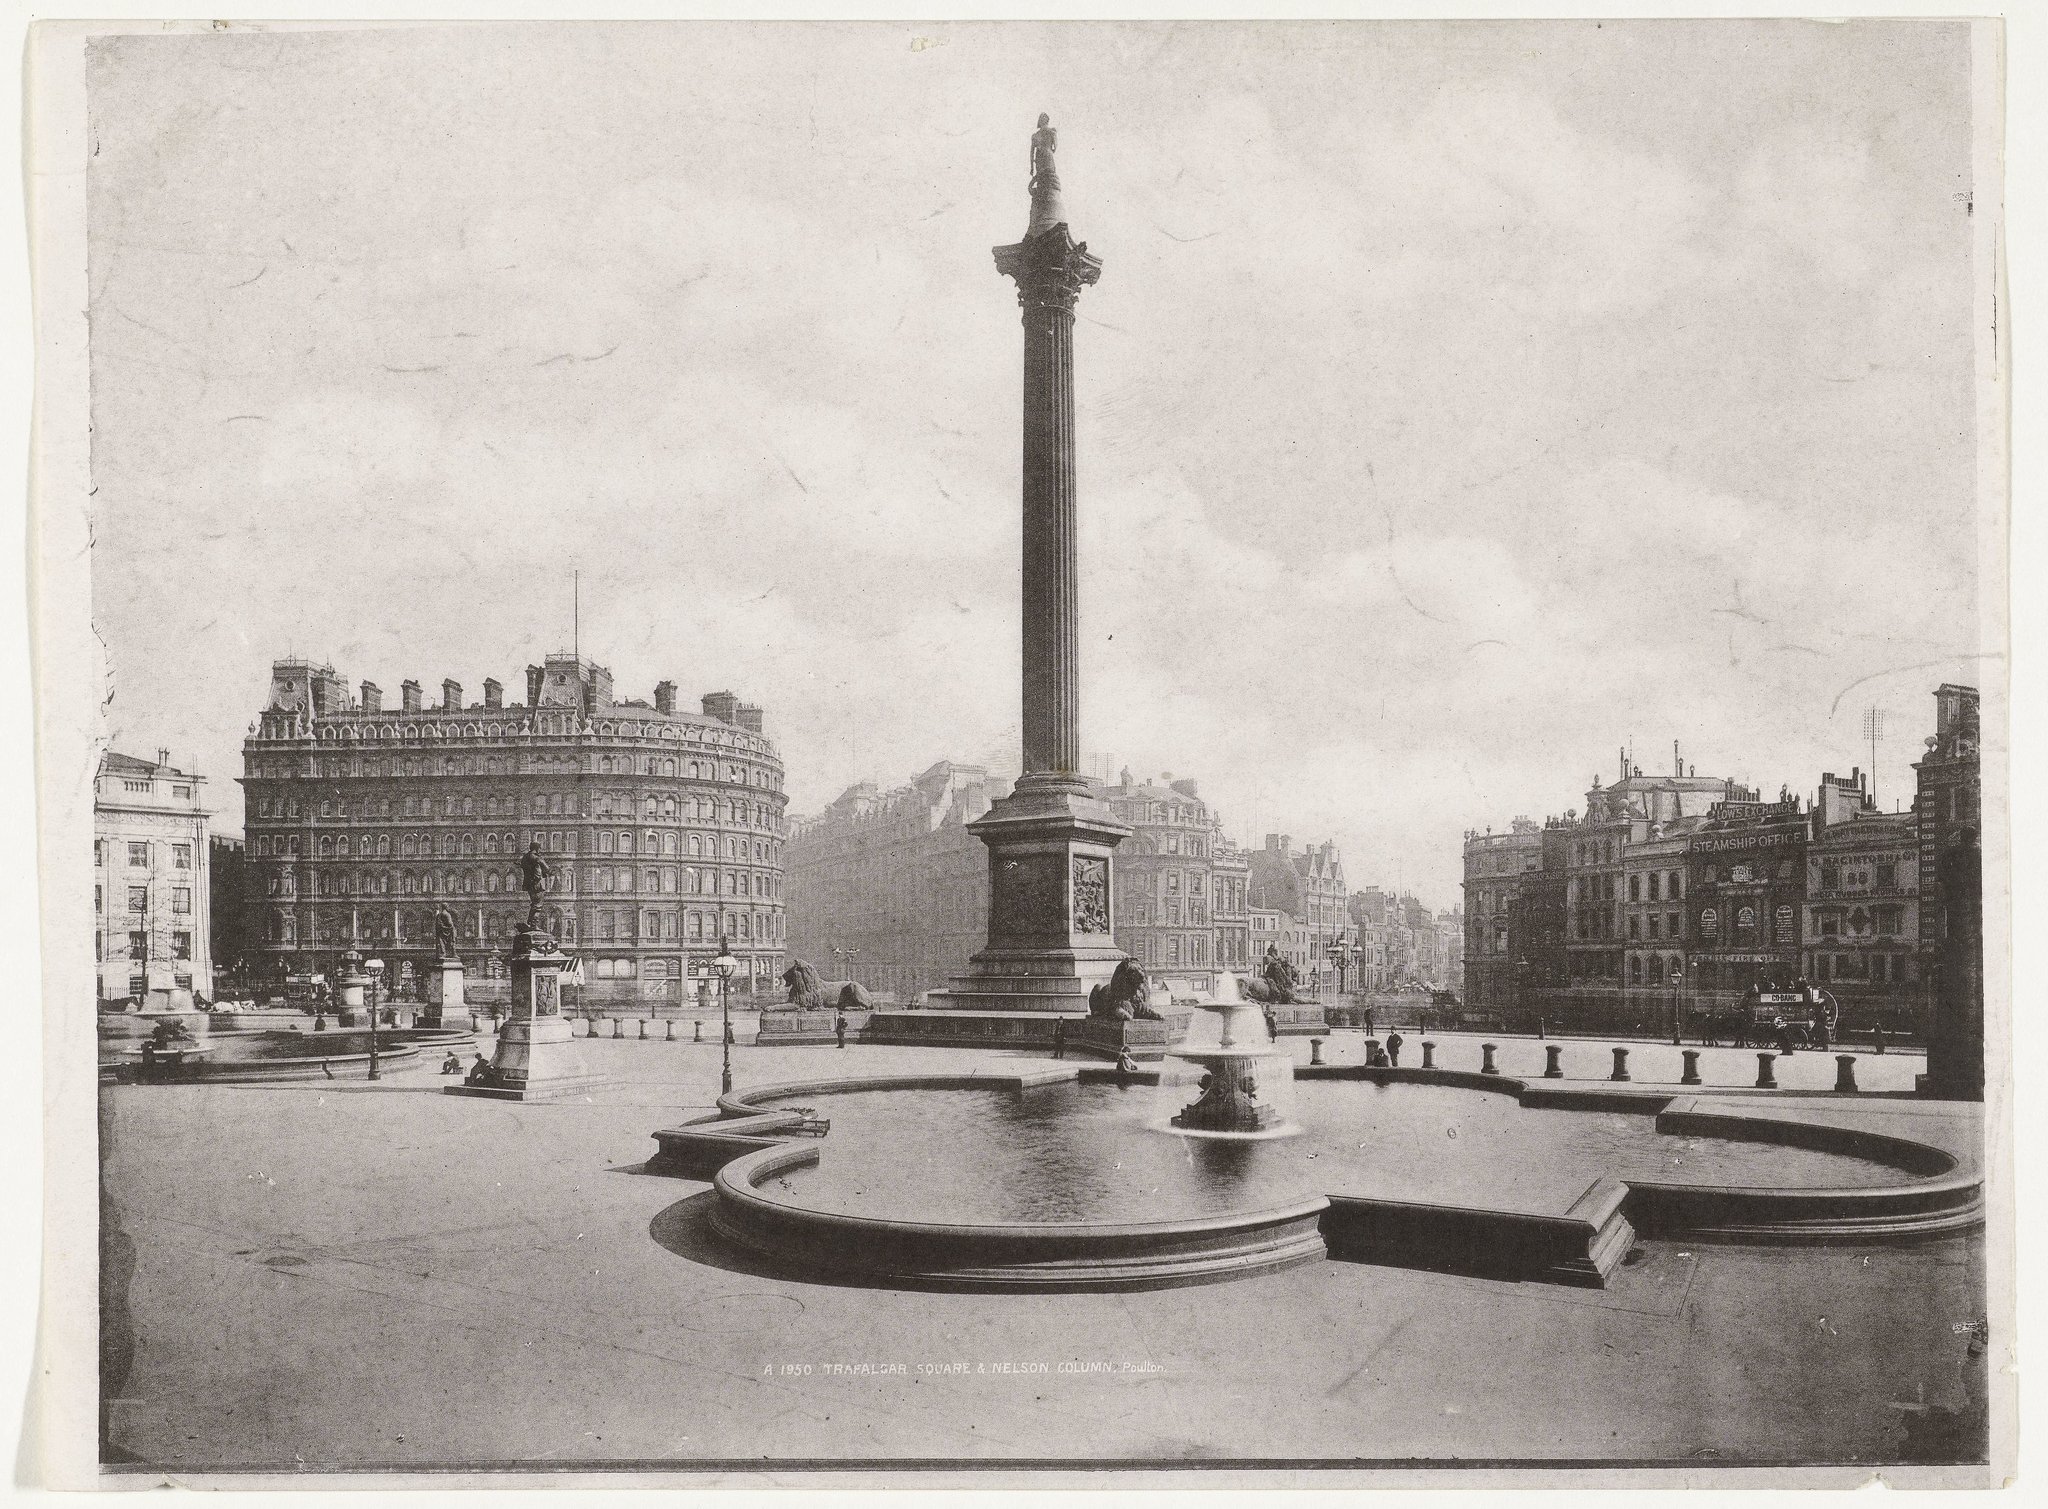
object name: photomechanical print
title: Gezicht op Trafalgar Square met Nelson's Column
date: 1870-1888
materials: paper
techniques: photograph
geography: london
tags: square, place, circus, etc.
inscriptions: number: ‘A 1950’